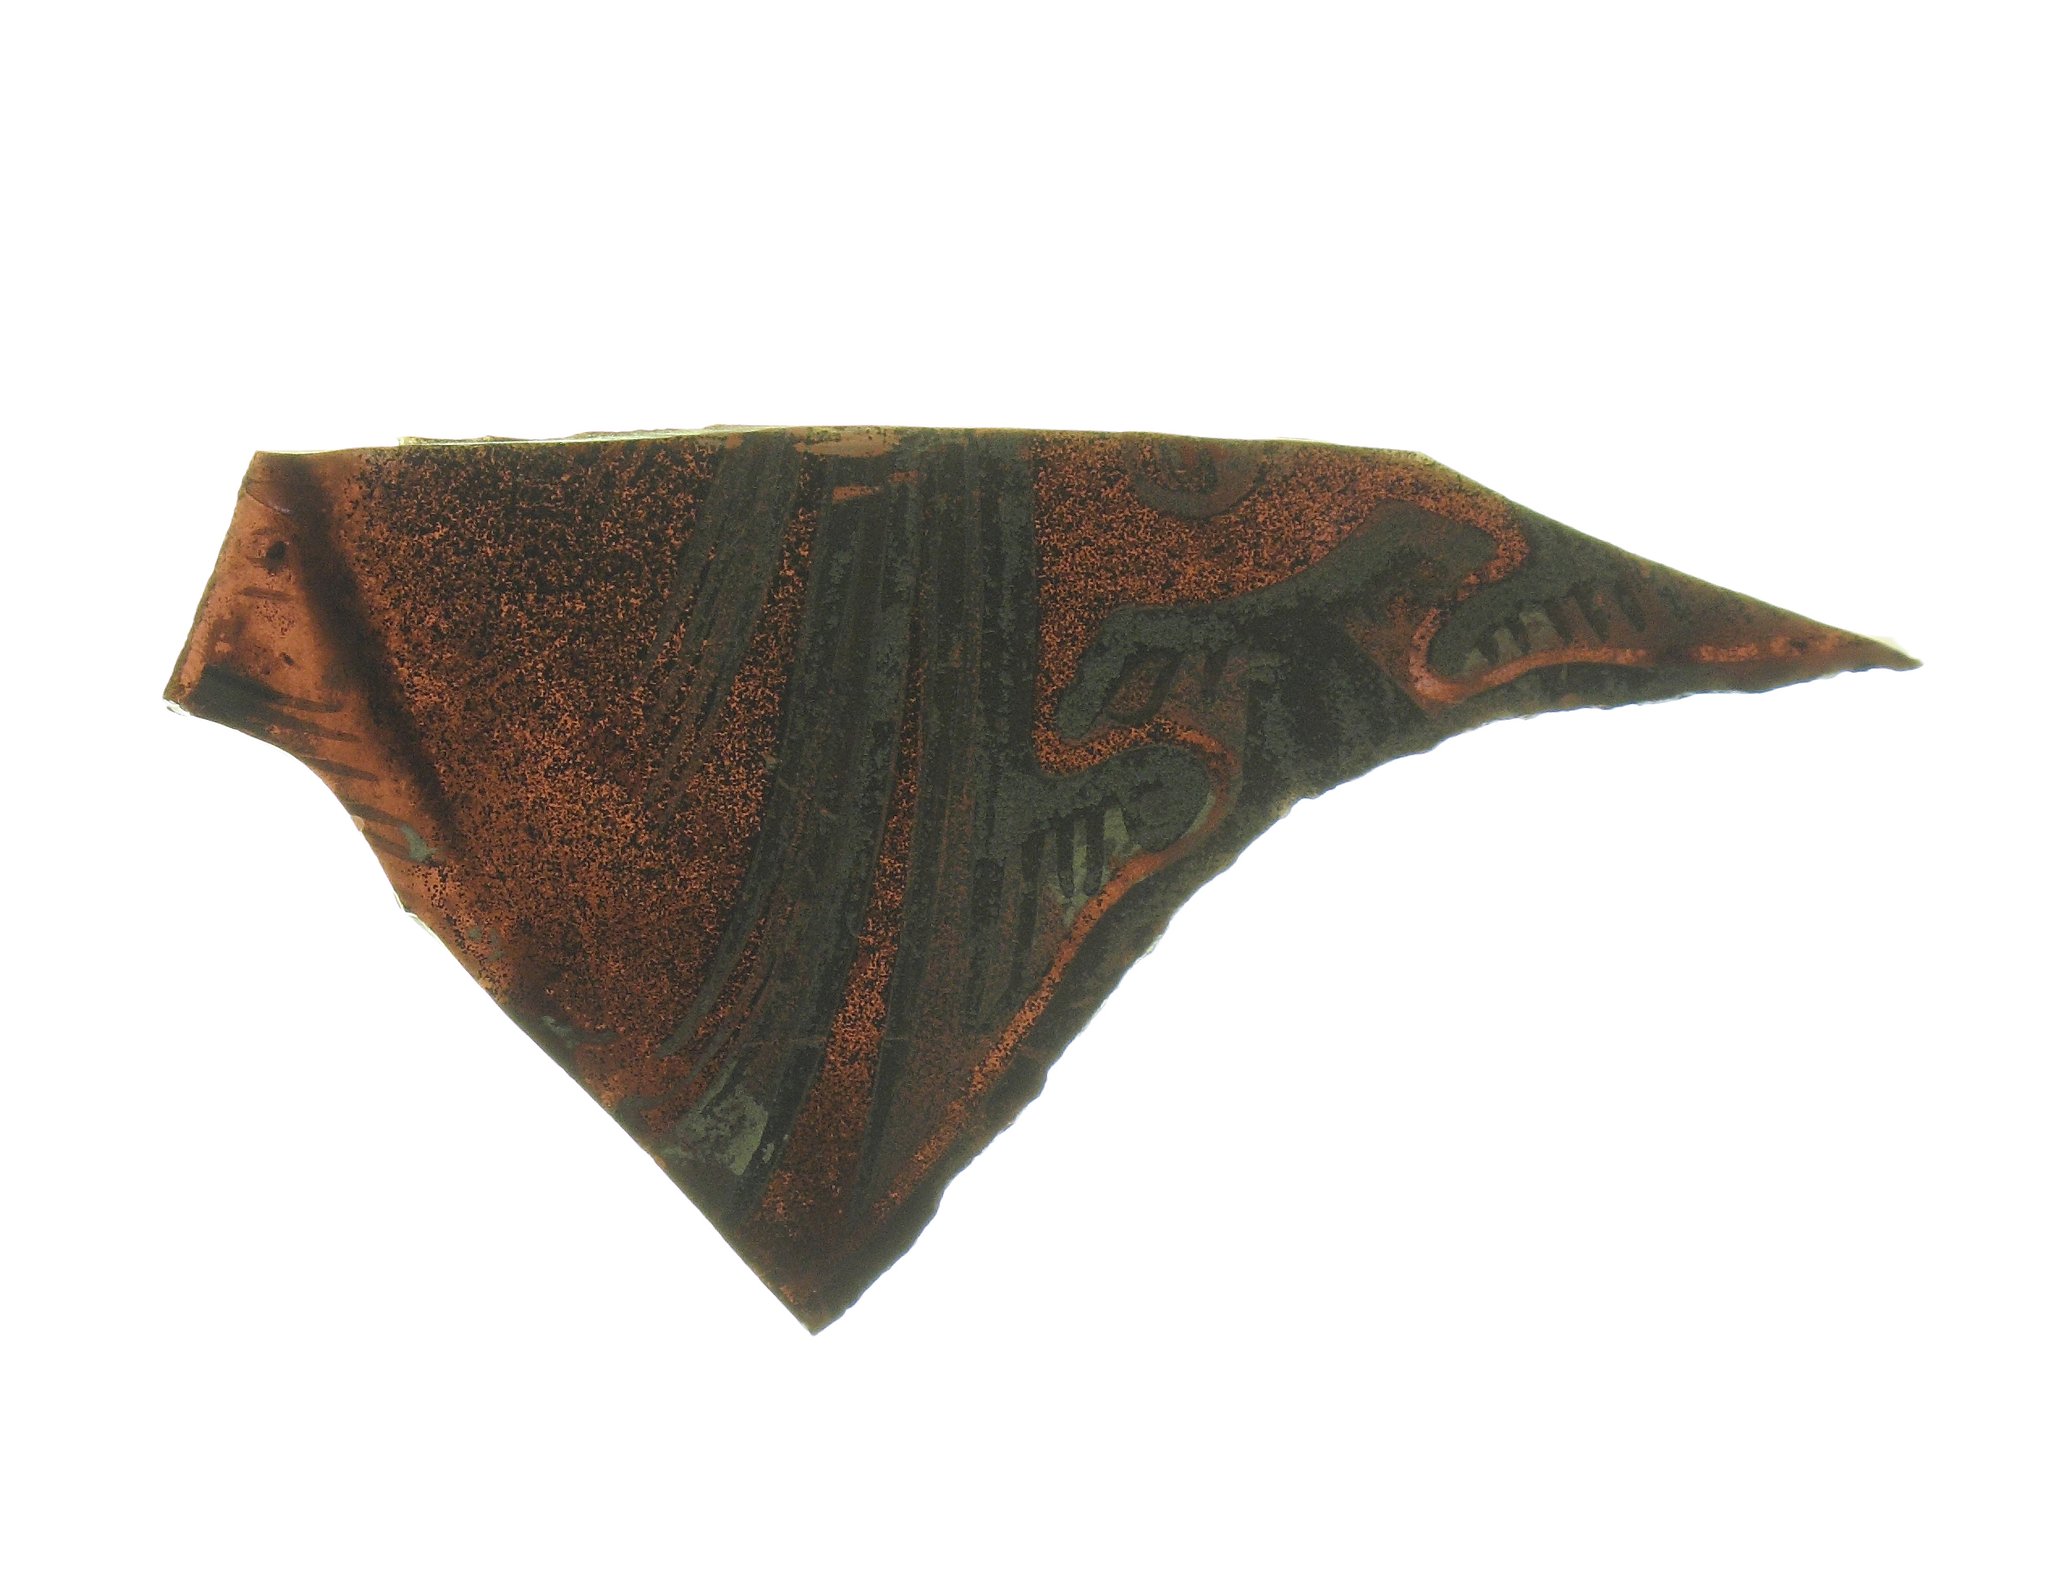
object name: fragment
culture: french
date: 1101-1400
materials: glass, metal, paint